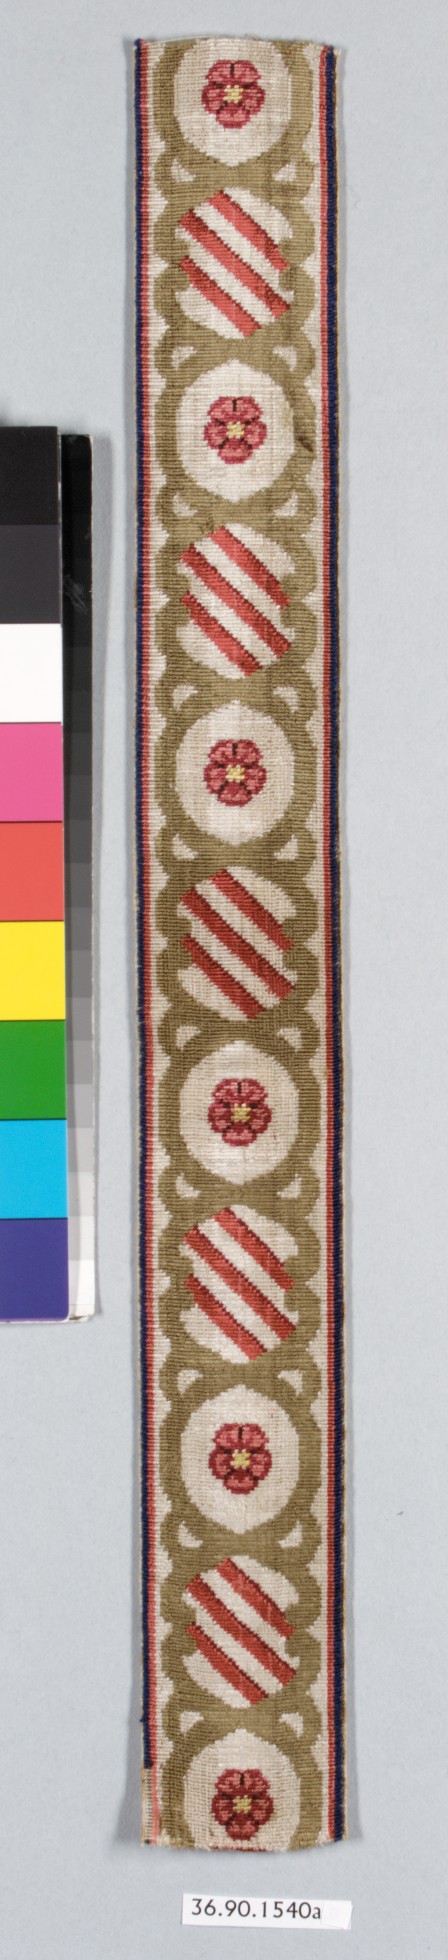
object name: galloon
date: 1701-1900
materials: silk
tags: flowers